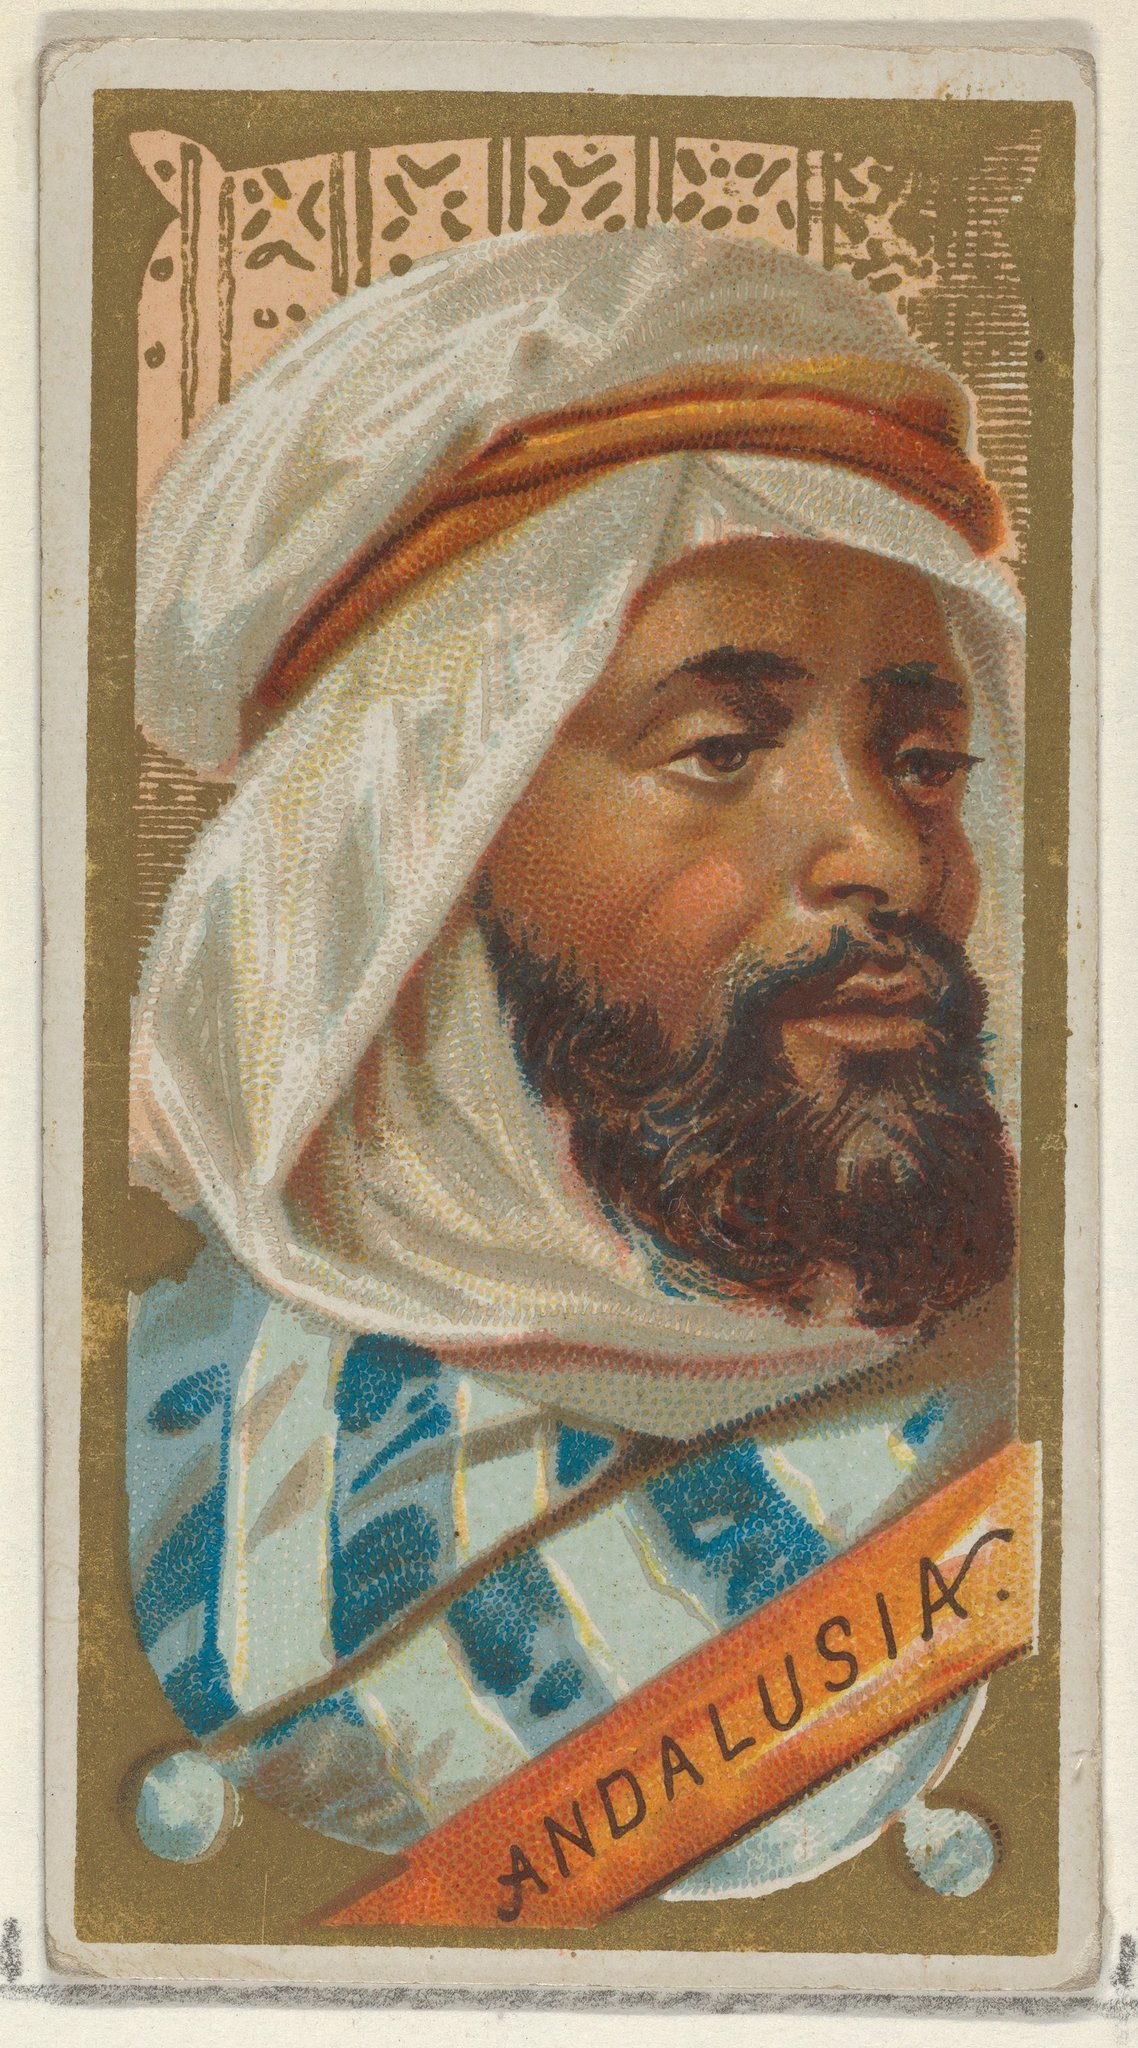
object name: print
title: Andalusia, from the Types of All Nations series (N24) for Allen & Ginter Cigarettes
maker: allen & ginter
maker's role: publisher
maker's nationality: american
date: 1889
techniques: color lithograph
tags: men